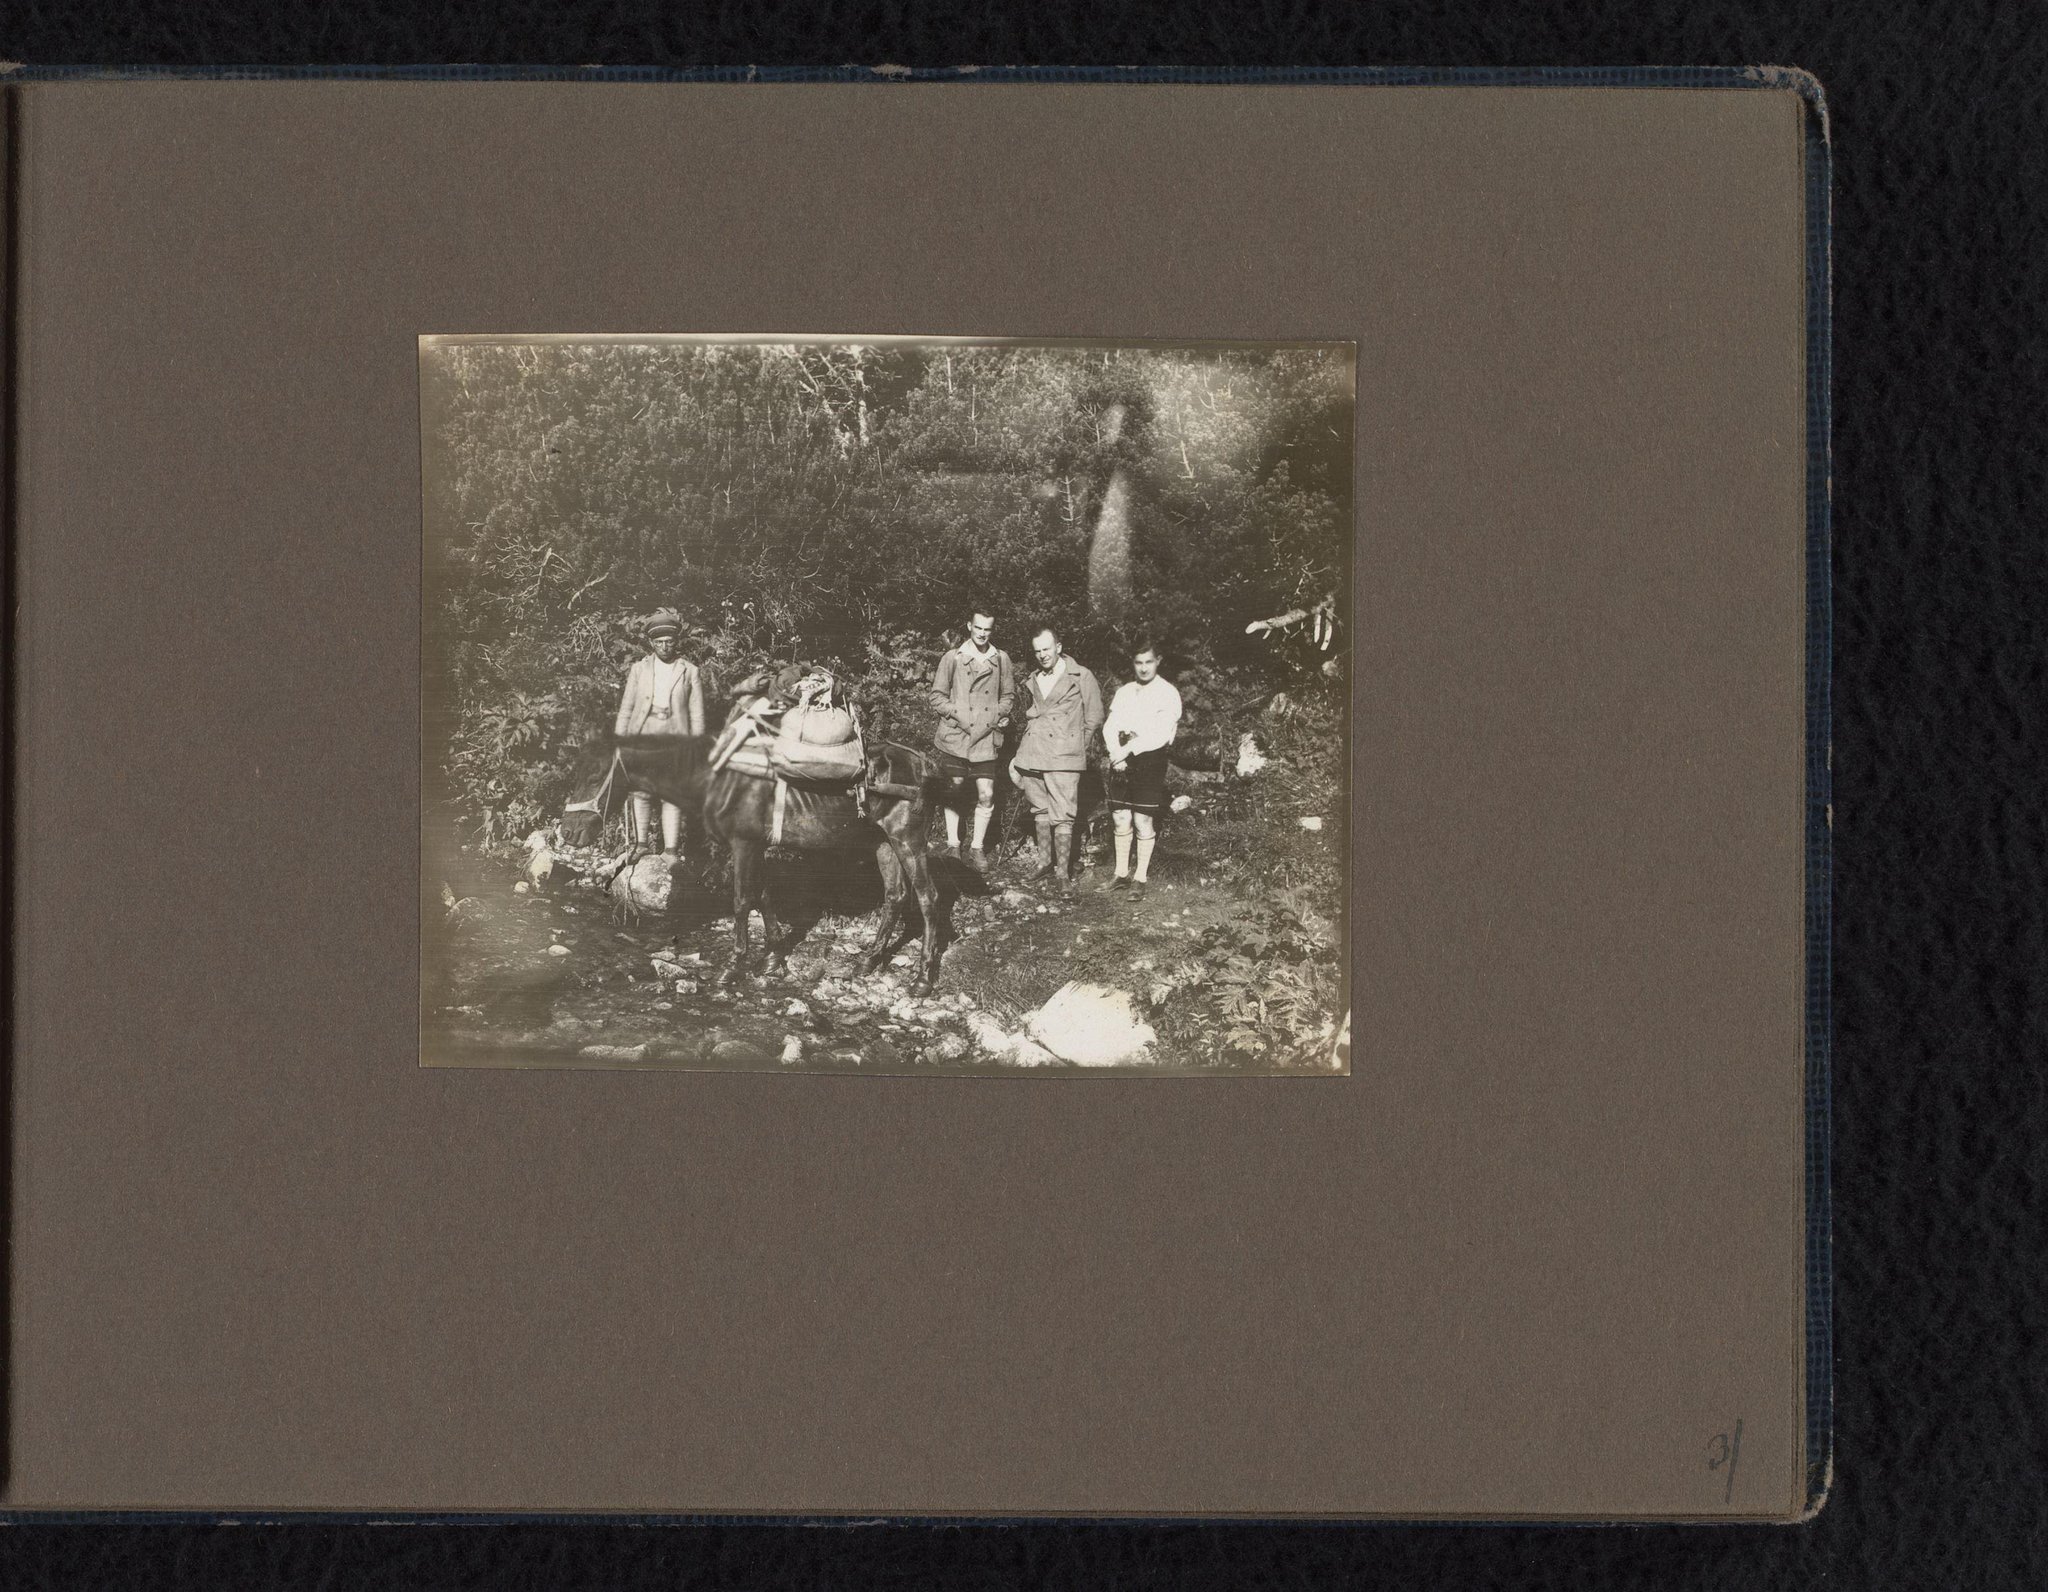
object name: photograph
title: Mannen met een ezel in Bulgaars berglandschap, tijdens een rondreis van Eugen Wachenheimer en zijn echtgenote Else Wachenheimer-Moos door Bulgarije, 1923-1923, (mogelijk omgeving Sofia)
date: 1922-1923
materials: paper, photographic support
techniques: gelatin silver print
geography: bulgaria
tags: walking, hiking (recreation), mule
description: Albumblad bevat een foto's van vier onbekende mannen. Uit album half formaat, blauw kunstlederen omslag met koordbinding.